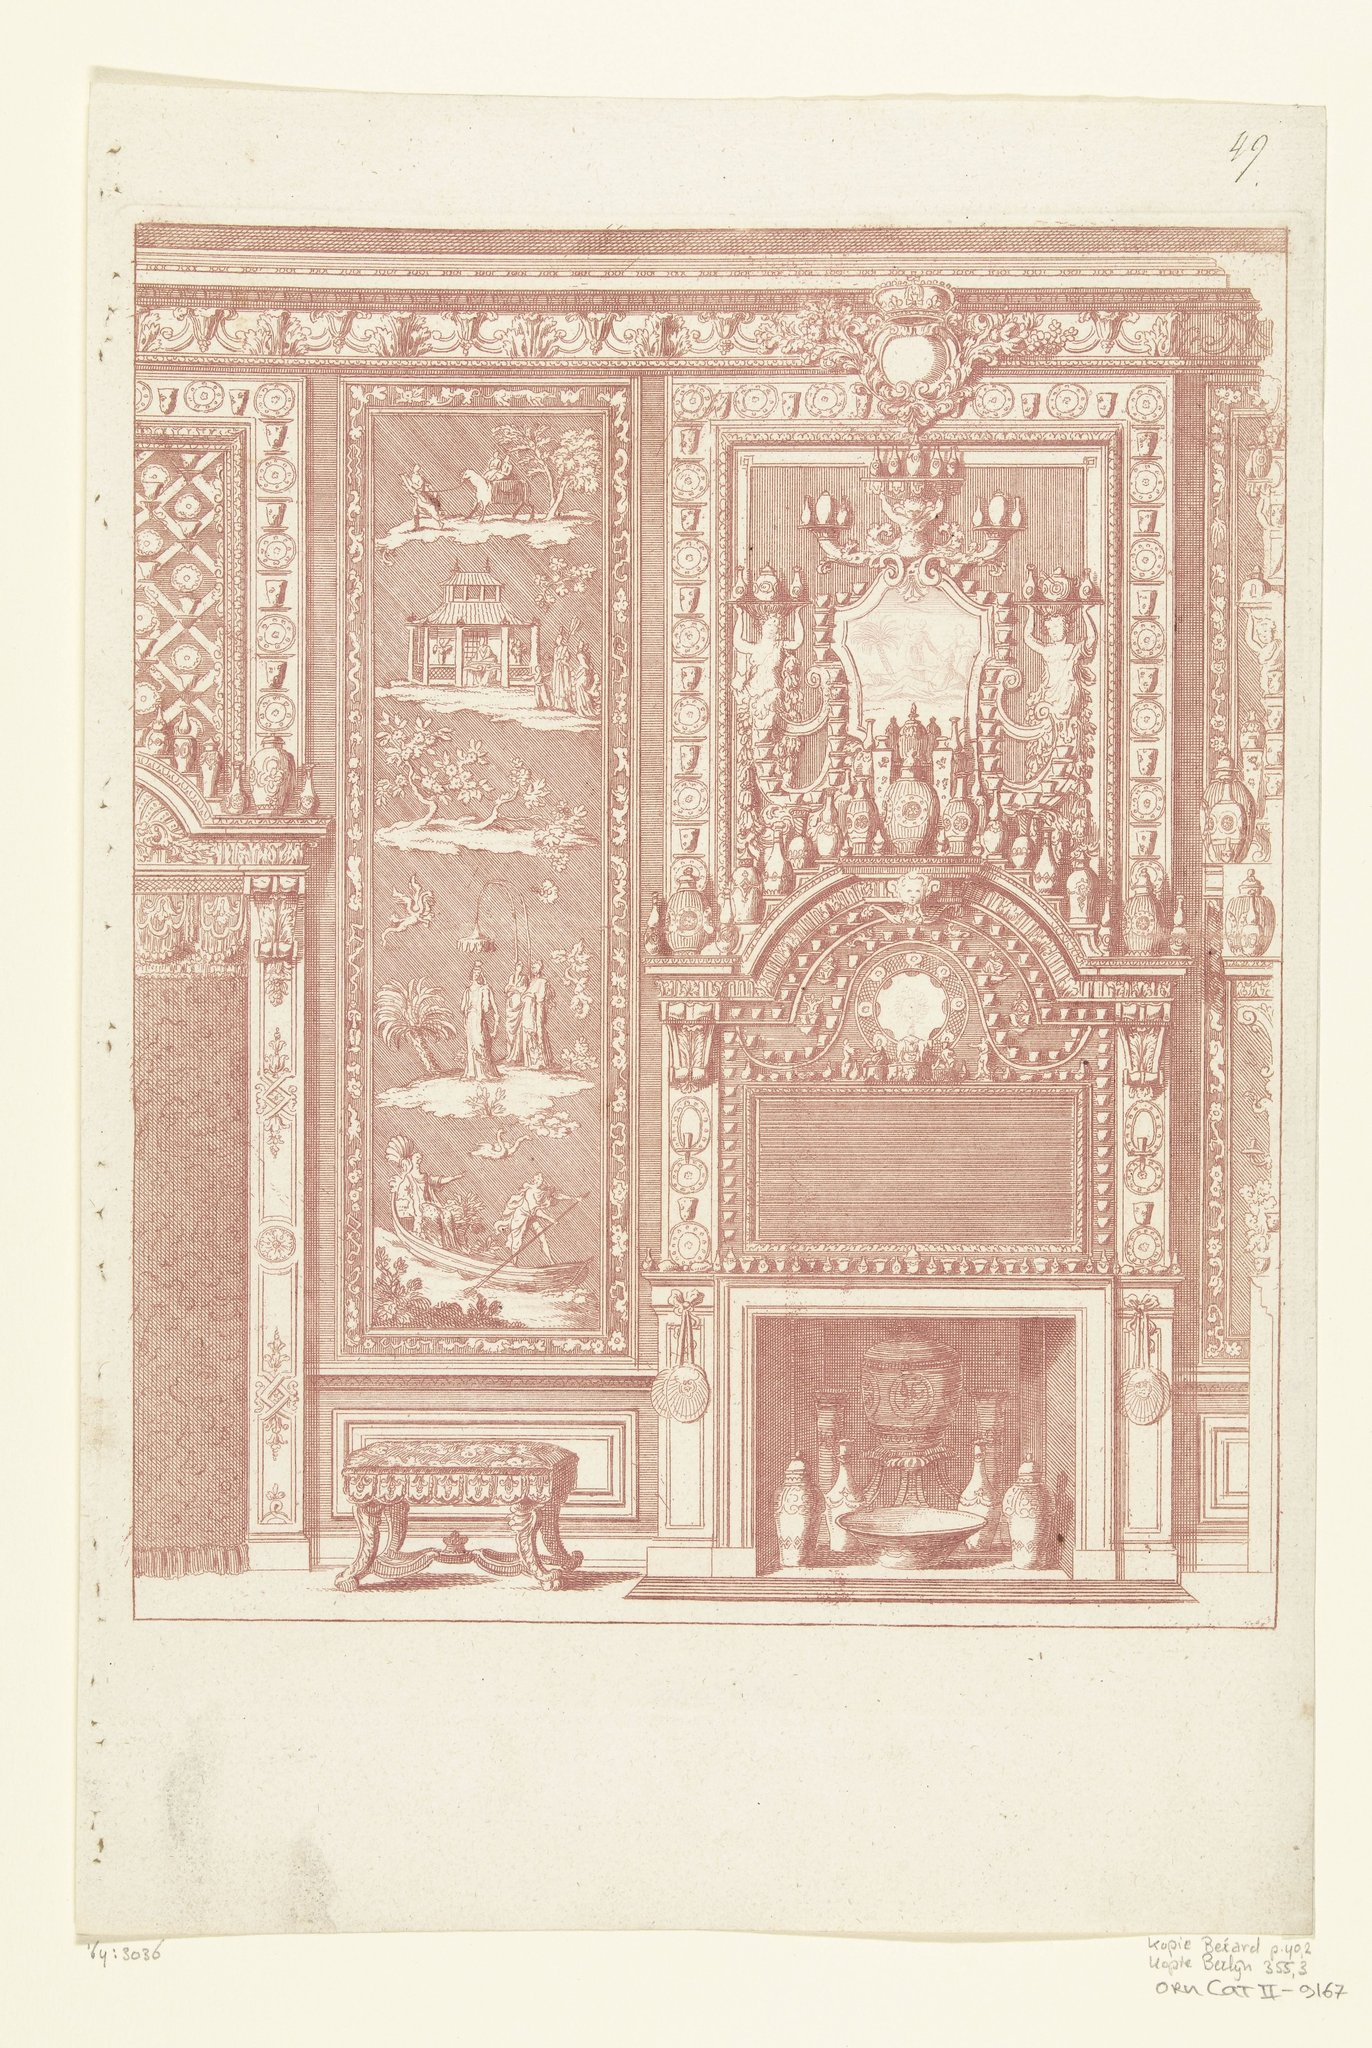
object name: print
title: Schouw voor een wand met lakwerk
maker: Anonymous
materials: paper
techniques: etching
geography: netherlands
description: Een schouw voor een wand met lakwerk. Links de helft van een deur met dessus-de-porte. Op de schouw en de kroonlijst van de deur staat een groot aantal Chinese porseleinen vazen. Kopie naar prent uit de serie Nouvelles Cheminée faittes en plusieur en droits de la Hollande et autres Prouinces.